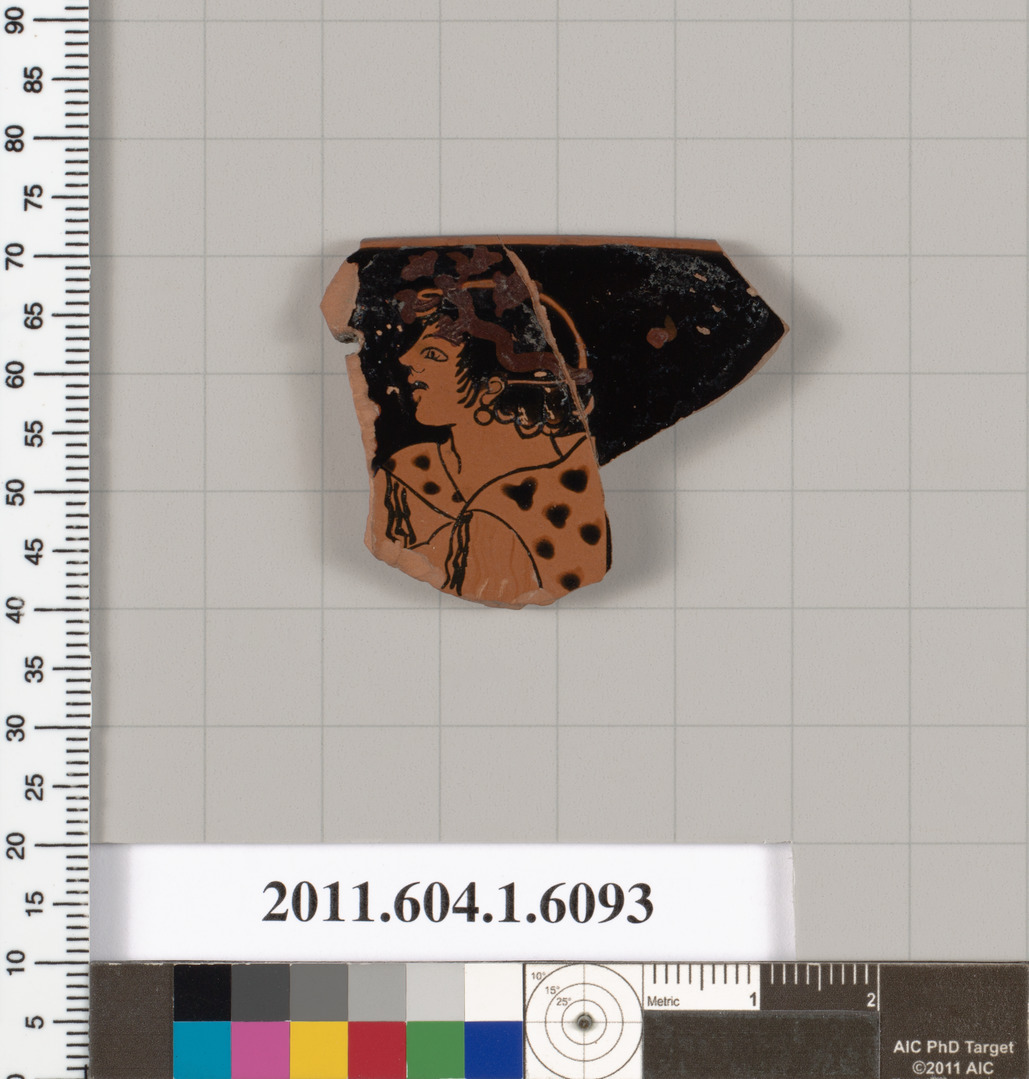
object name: kylix fragment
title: Terracotta rim fragment of a kylix (drinking cup)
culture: greek, attic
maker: apollodoros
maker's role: artist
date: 500-490 BCE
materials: terracotta